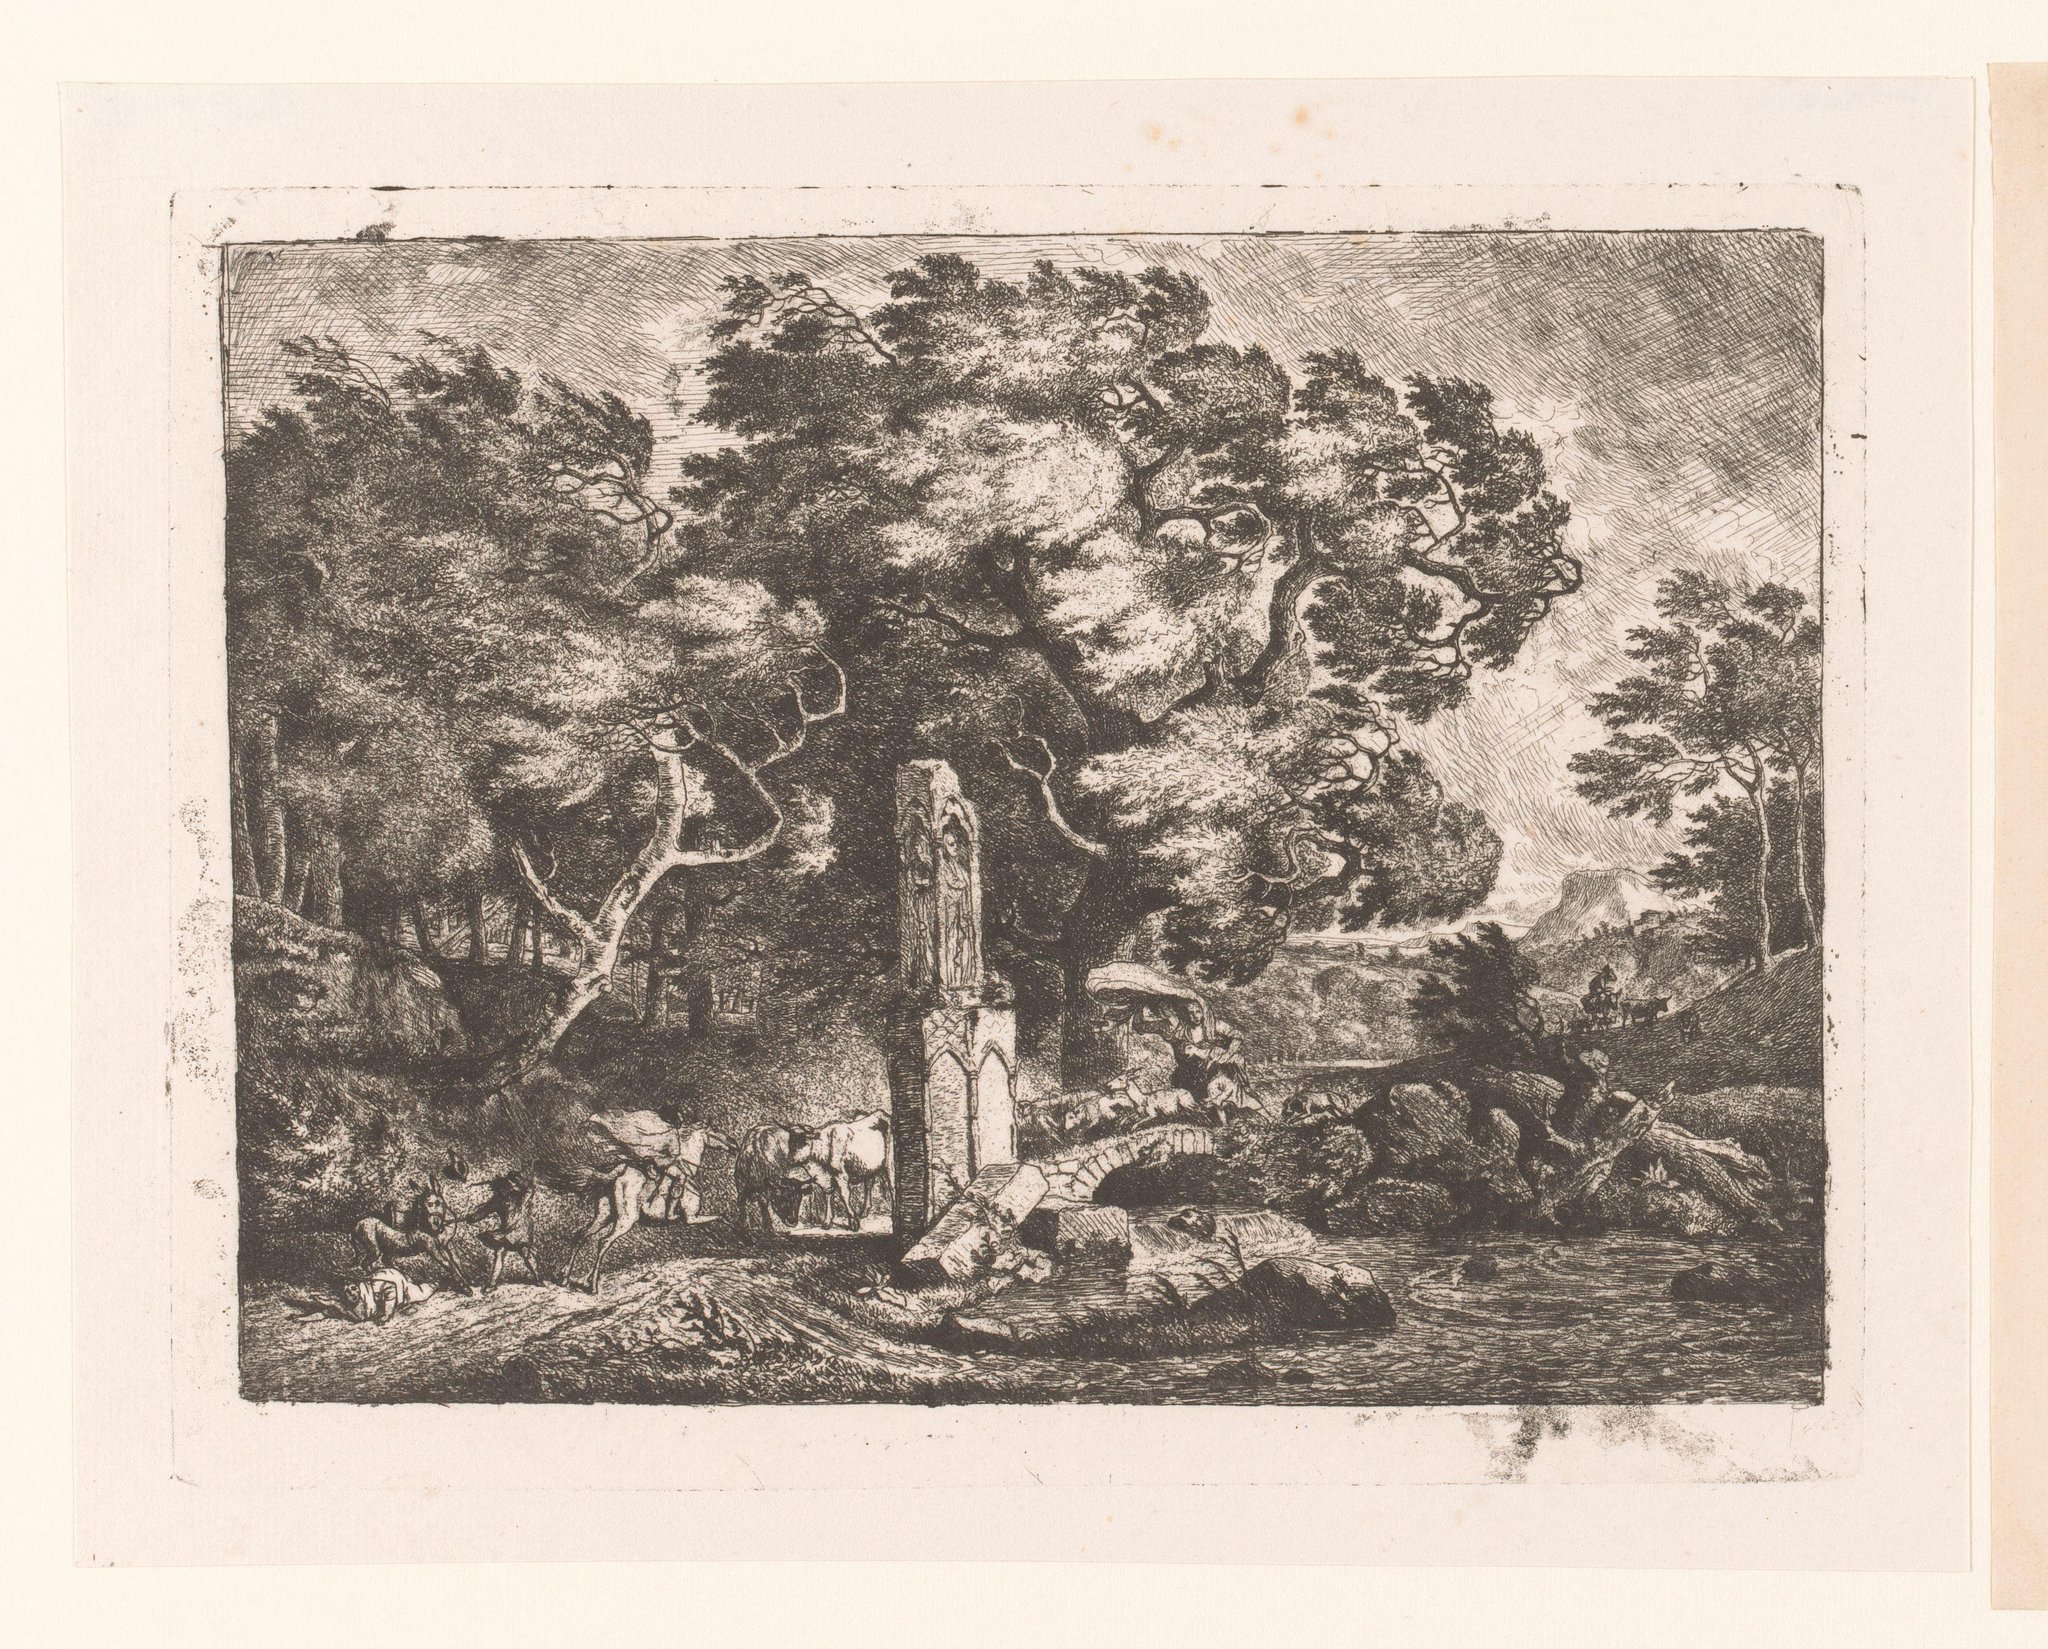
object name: print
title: Windvlaag waait langs bomen en een stenen brug met figuren en dieren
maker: jean louis demarne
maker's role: draughtsman, painter, print maker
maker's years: 1752-1829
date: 1762-1829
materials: paper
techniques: etching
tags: animals, landscapes with waters, waterscapes, seascapes (in the temperate zone), winds, bridge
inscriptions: collector's mark: Lugt 2228